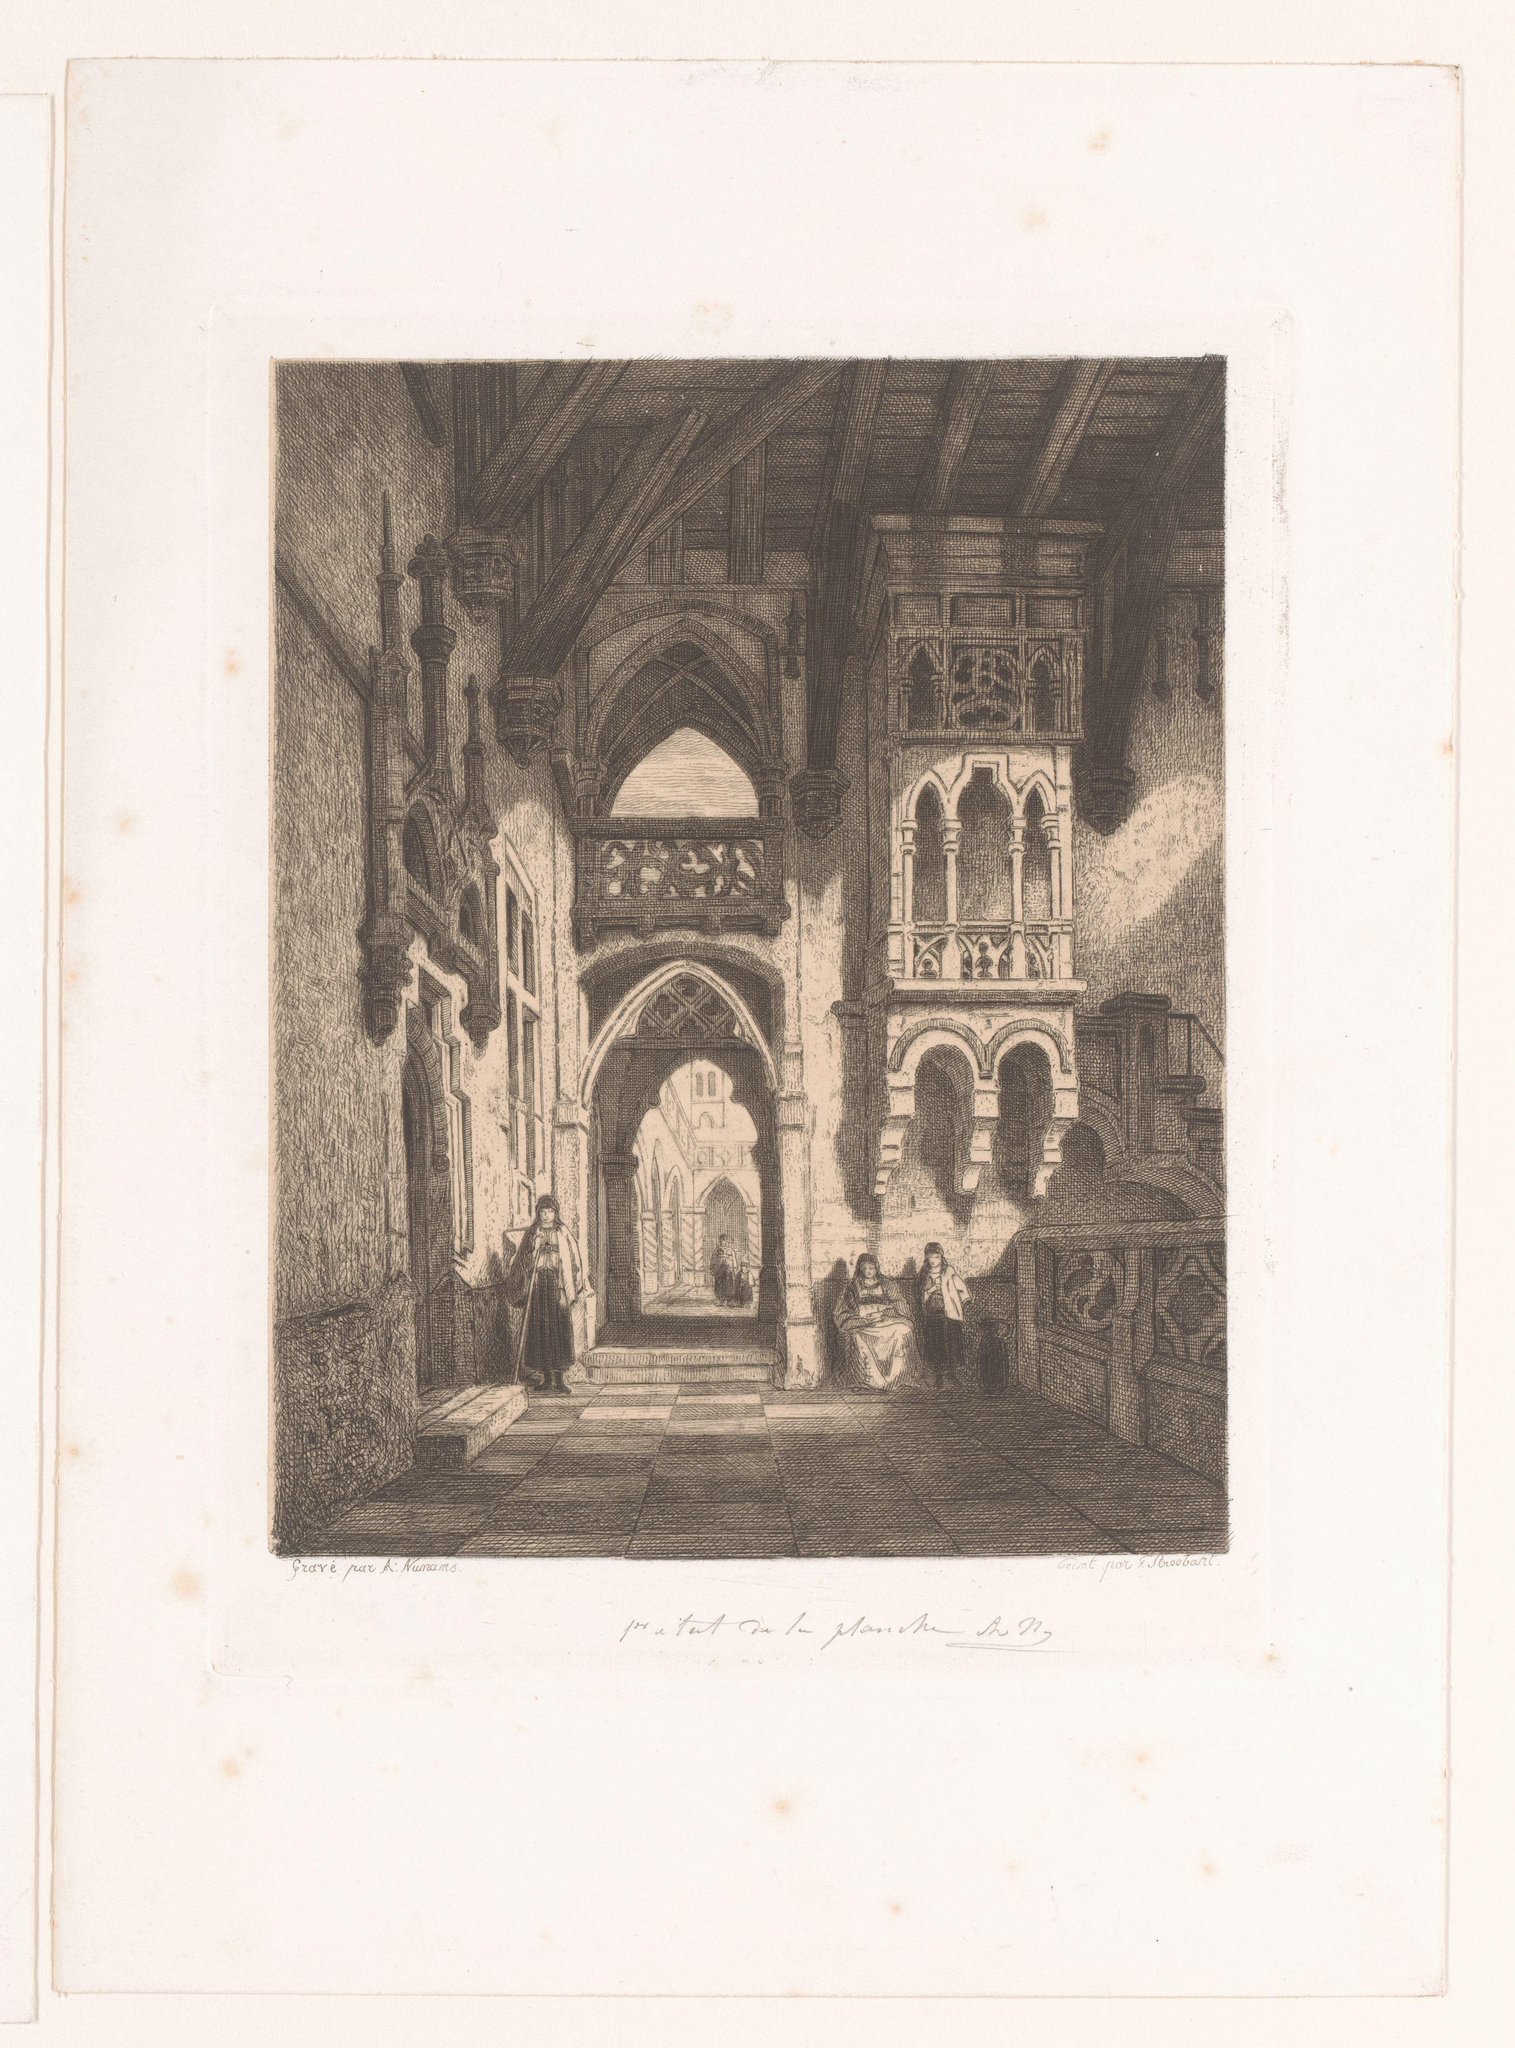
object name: print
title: Gotische binnenplaats in Galicië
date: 1872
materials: paper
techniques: etching, intaglio, roulette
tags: interior ~ representation of a building, civic architecture; edifices; dwellings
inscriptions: collector's mark: Lugt 2228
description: Latere staat van deze prent verschenen in: Album du journal des Beaux-Arts, dix eaux-fortes inédites. Antwerpen: Typographie A. Fontaine, 1872.